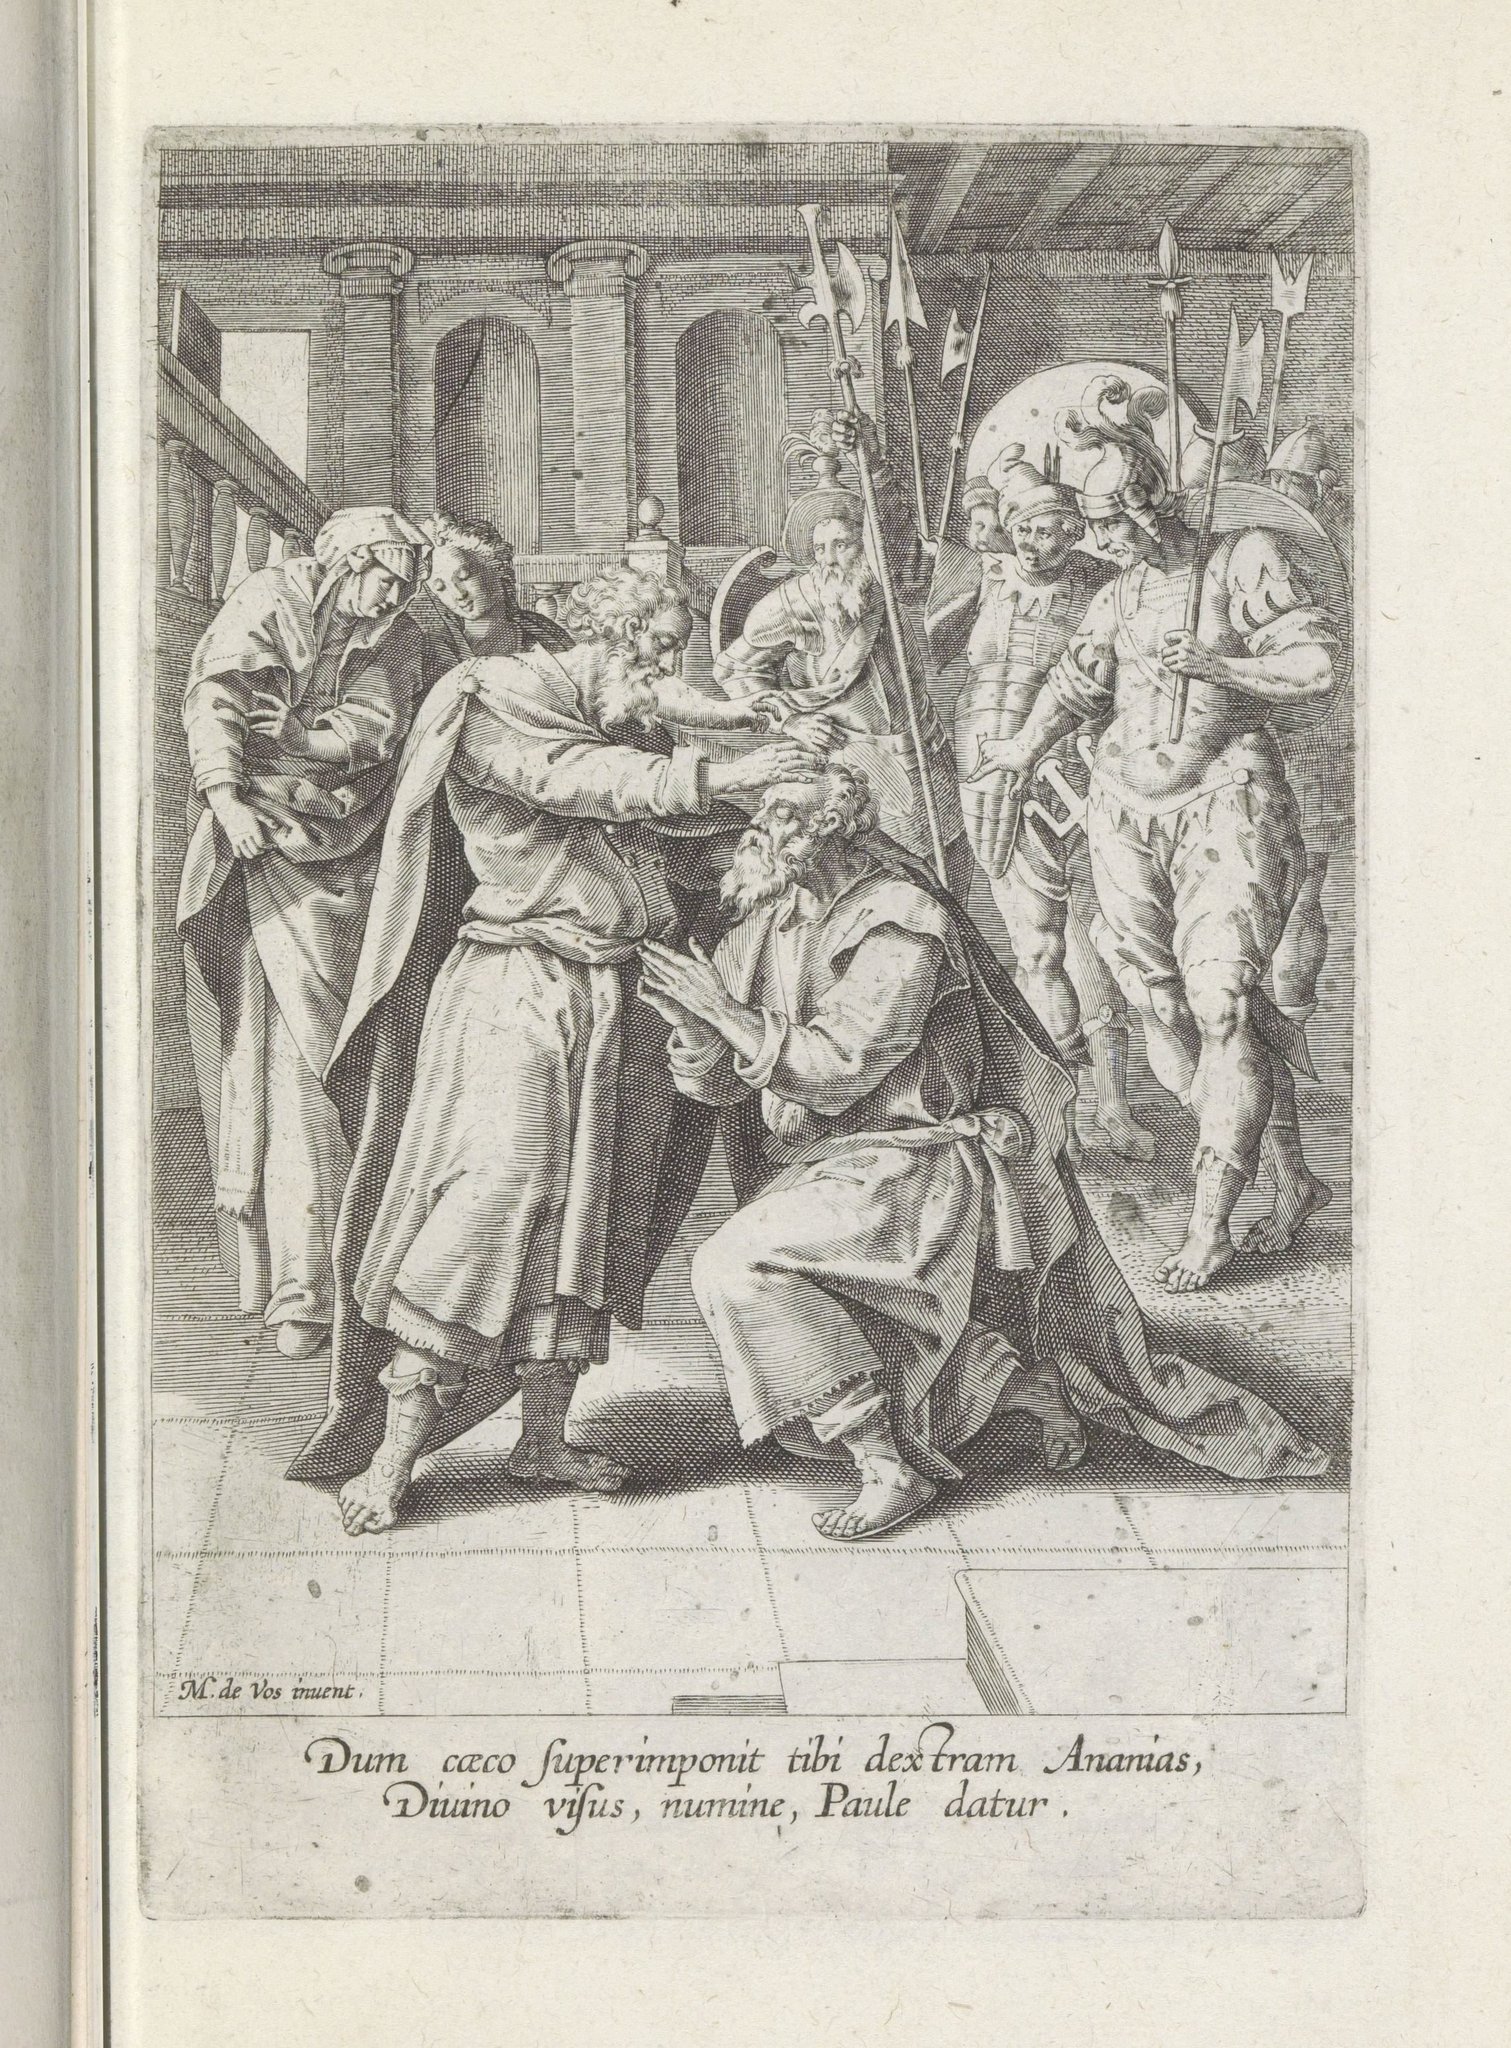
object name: album leaf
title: Handelingen van de apostelen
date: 1585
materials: paper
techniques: engraving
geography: antwerp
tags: ananias restores saul's sight by laying on hands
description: Deze serie draagt op een van de prenten het signatuur van de weduwe van uitgever Gerard de Jode. De eerste datering is gebaseerd op de datum van uitgave van het album. De tweede datering is gebaseerd op het sterfjaar van Gerard de Jode (1591) en het jaar waarin zijn zoon overleed (1600) en de platen werden verkocht. Het is mogelijk dat deze serie later aan het album is toegevoegd. Waarschijnlijker is het dat het gehele album tussen 1591 en 1600 is gebonden, omdat deze serie is meegebonden in het album.